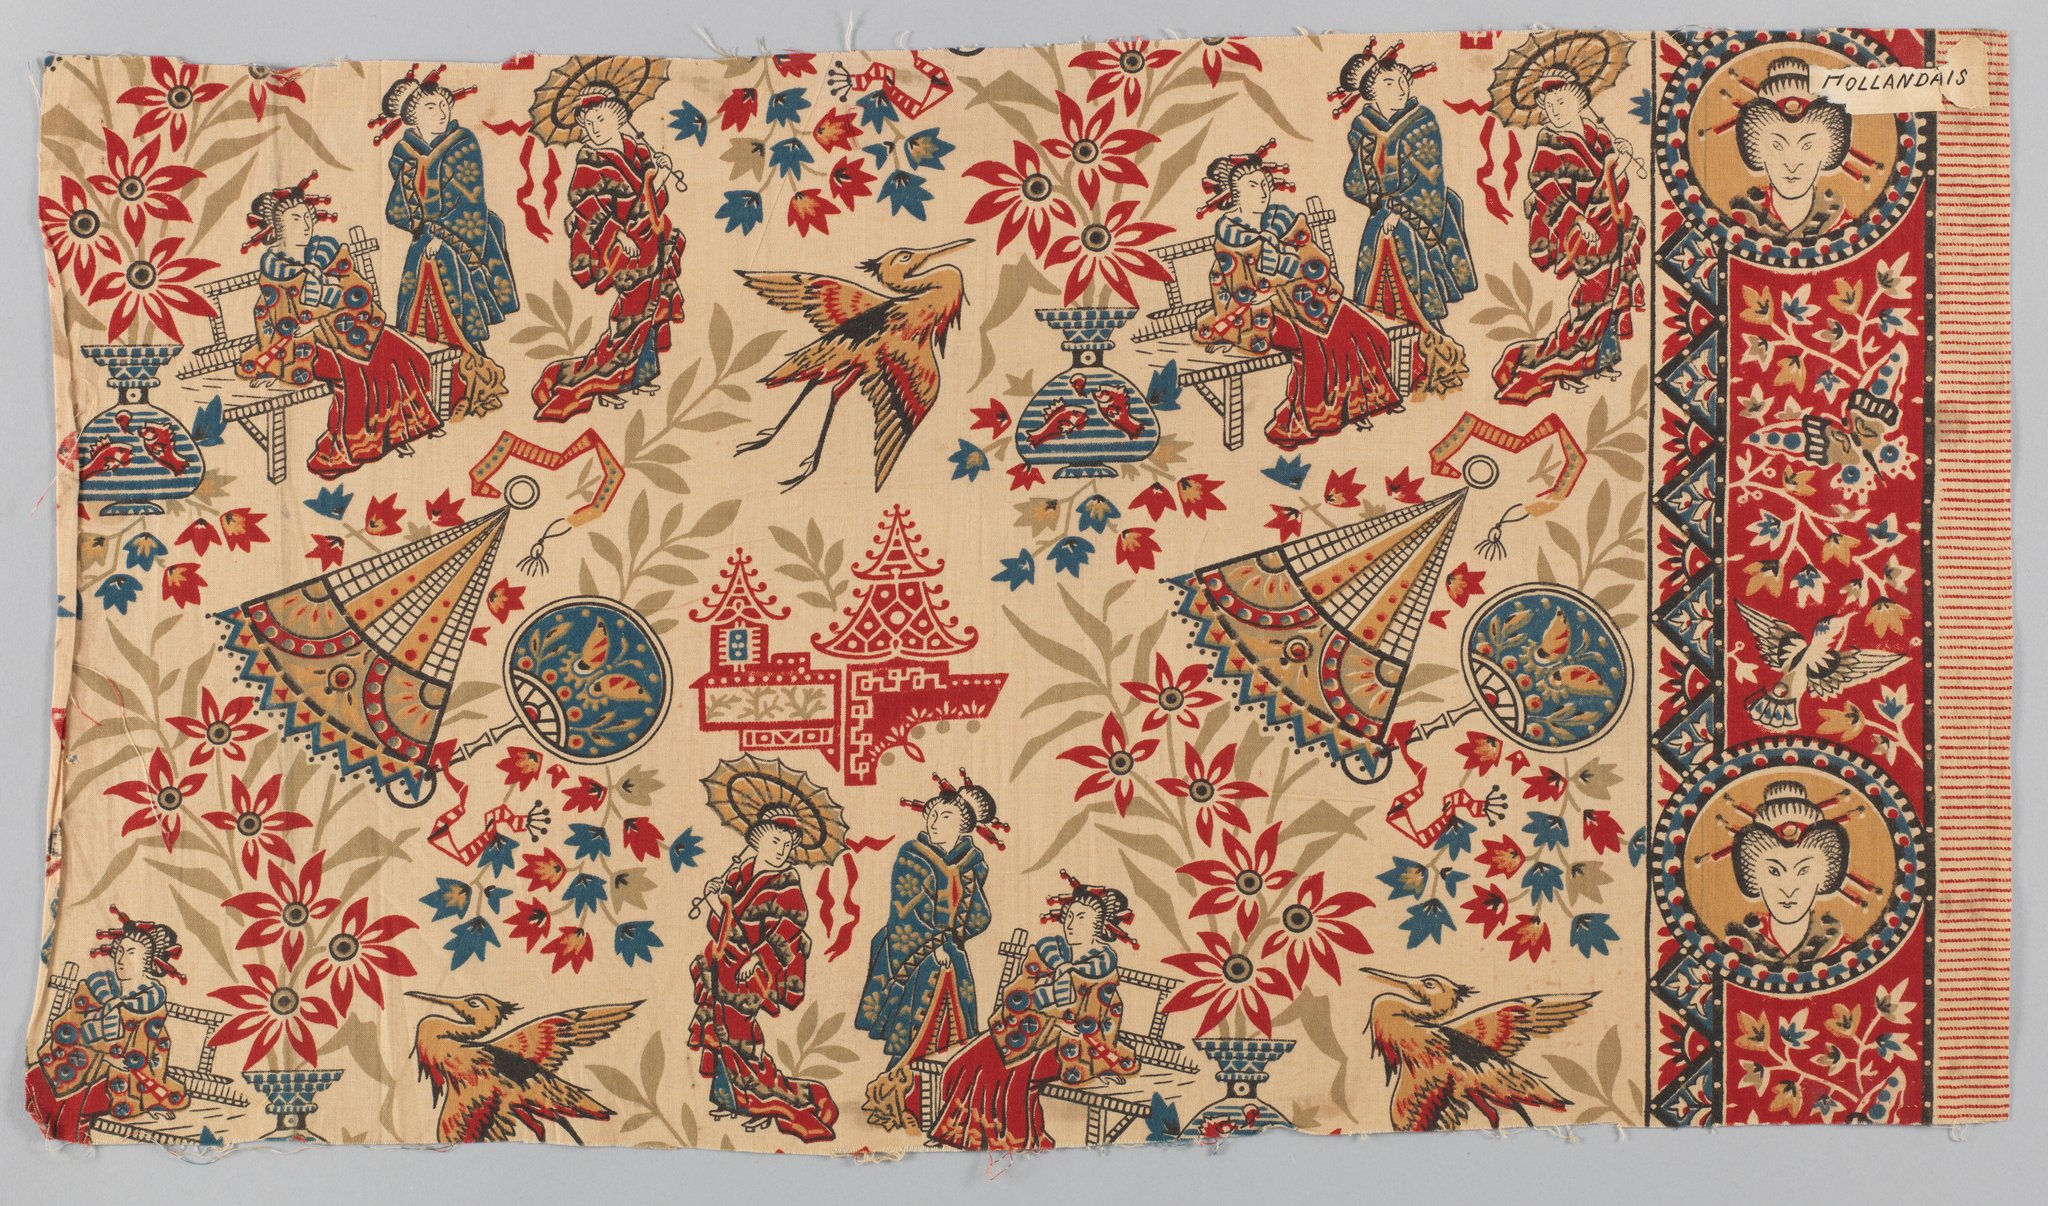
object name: piece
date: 1801-1900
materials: cotton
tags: birds,women